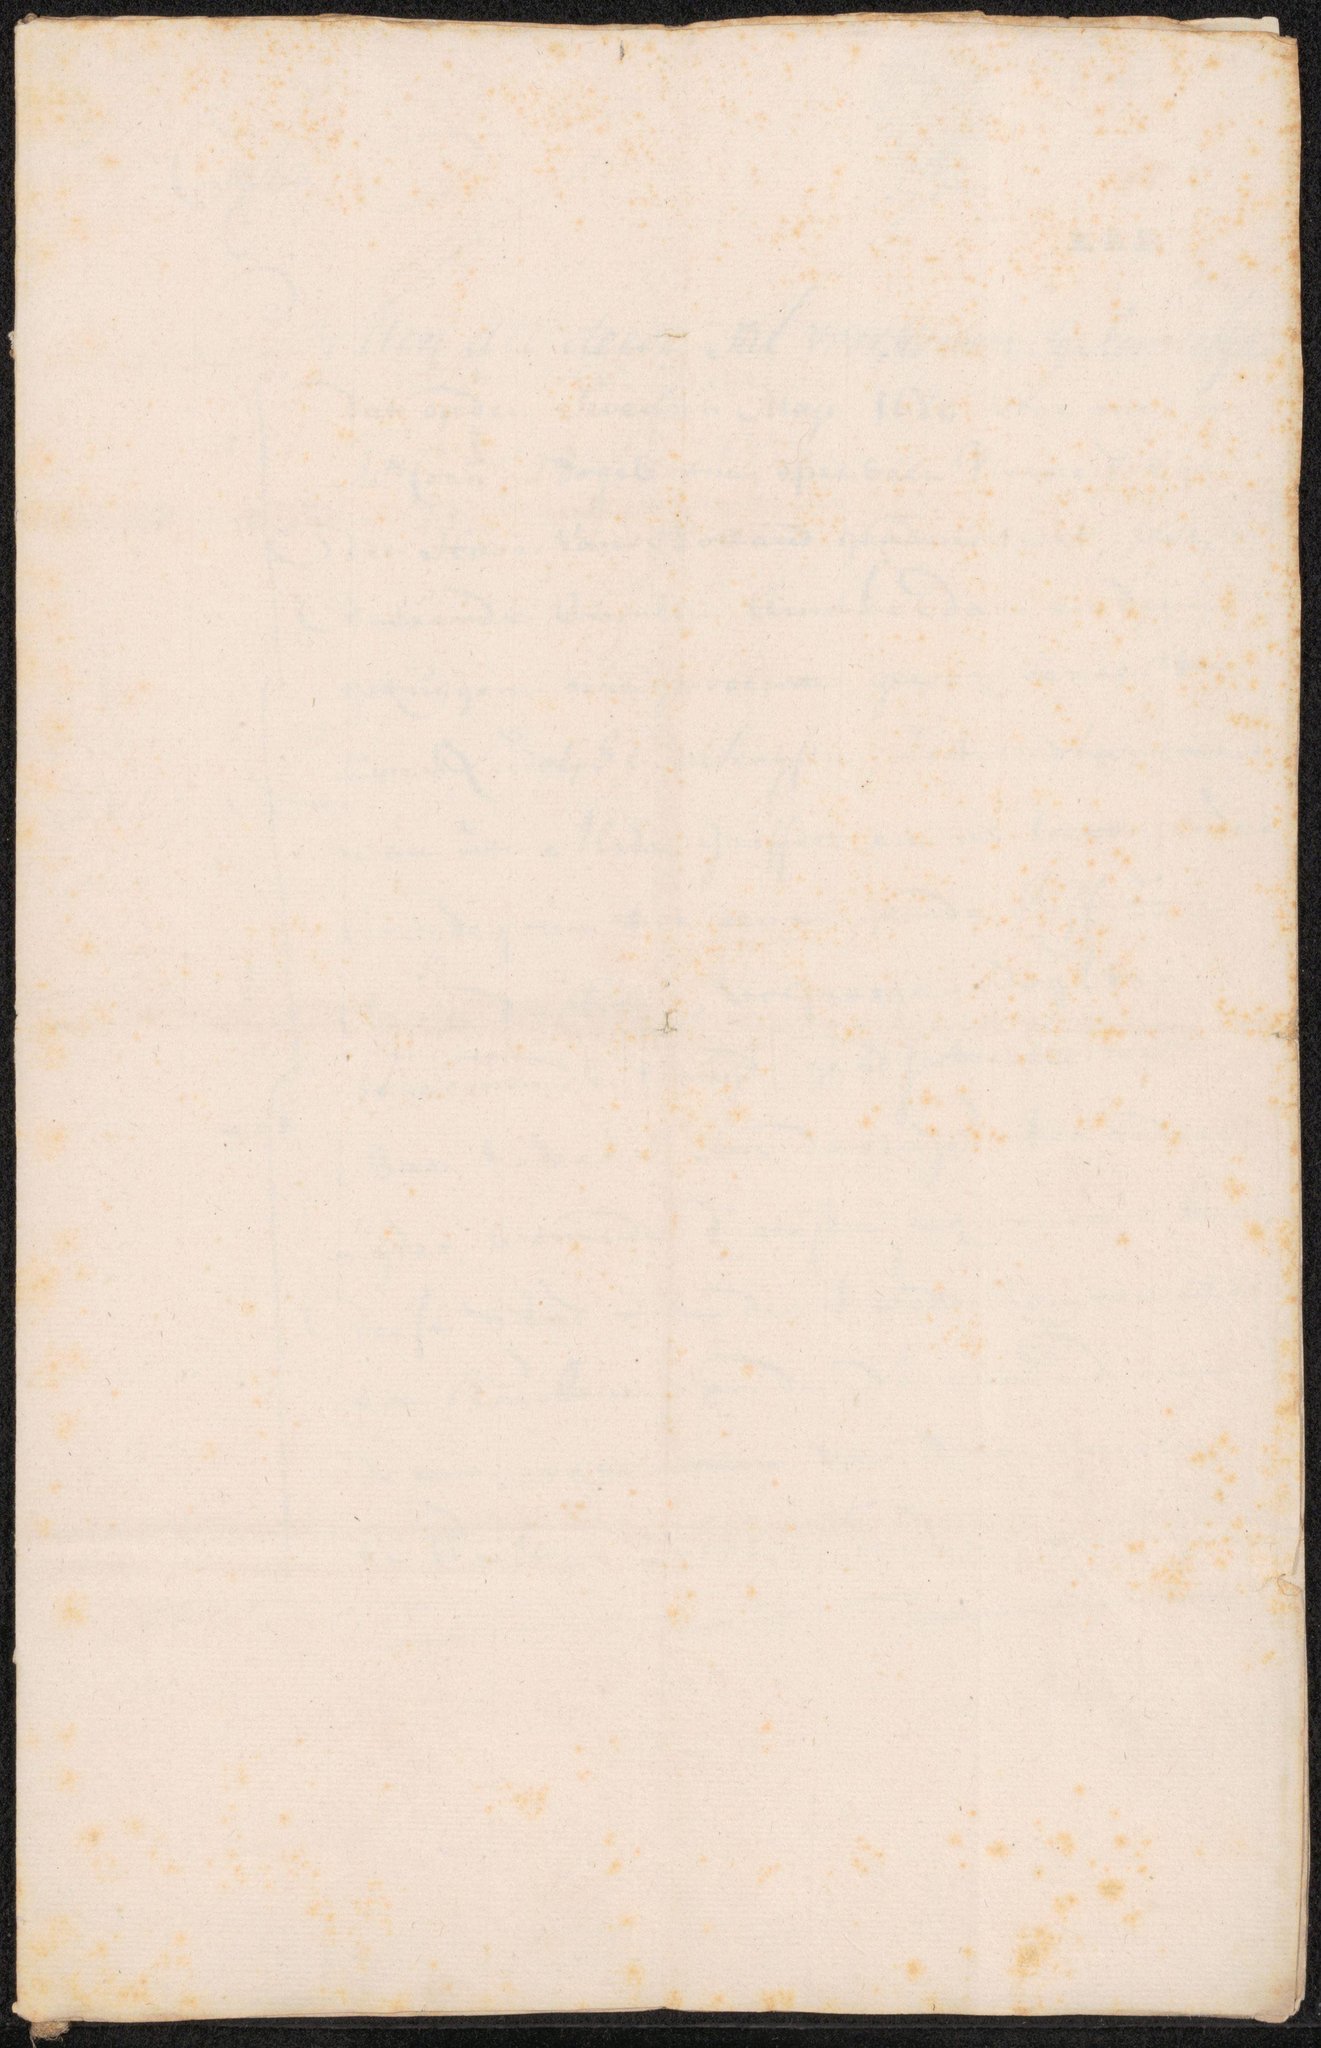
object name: manuscript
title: Kopie van contract van huwelijkse voorwaarden van Ludolf Bakhuysen en Anna de Hooghe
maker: Anonymous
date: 1699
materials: ink, paper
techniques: pen, writing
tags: london, johannes de hooghe (1608-1682), amsterdam, print maker, draughtsman, ludolf bakhuysen, anna de hooghe, family life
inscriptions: collector's mark: Lugt 2233